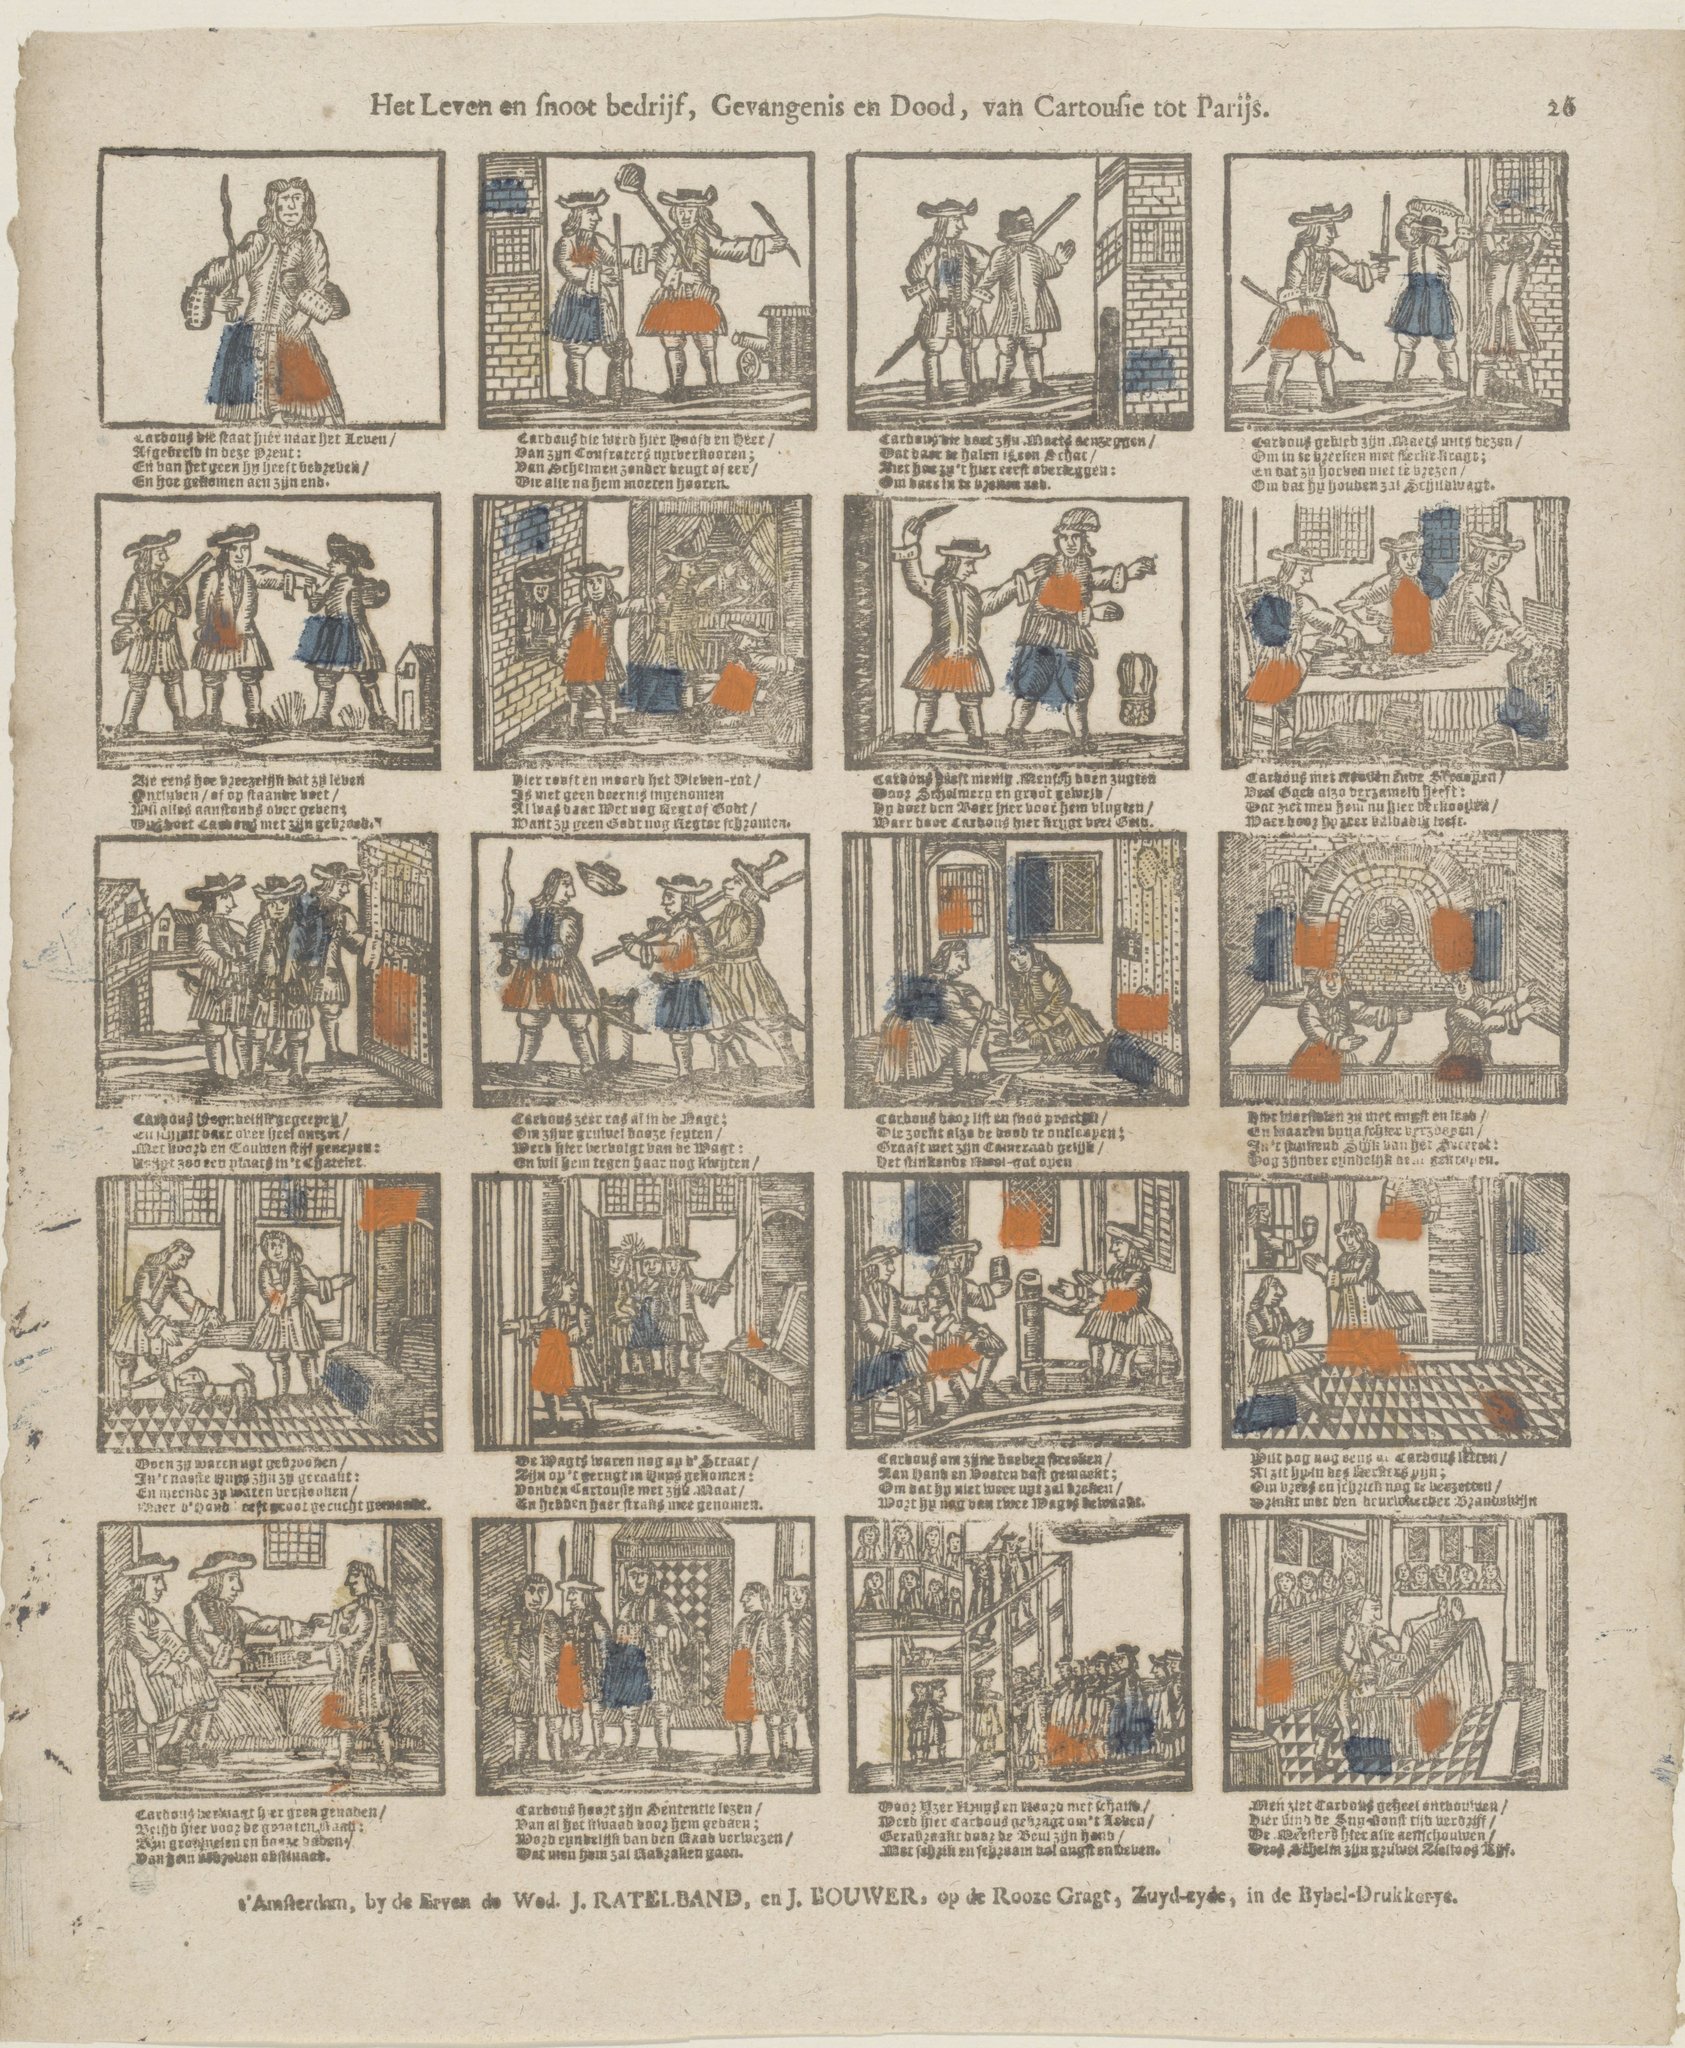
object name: popular print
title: Het leven en snoot bedrijf, gevangenis en dood, van Cartousie tot Parijs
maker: Anonymous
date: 1782-1793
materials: paper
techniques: colour, letterpress printing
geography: amsterdam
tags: violent death by hanging, bad behaviour, tales and fairy tales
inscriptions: collector's mark: Lugt 2760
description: Blad met 20 voorstellingen over het leven en de avonturen Cartouche. Onder elke voorstelling een vierregelig vers. Genummerd rechtsboven: 26.